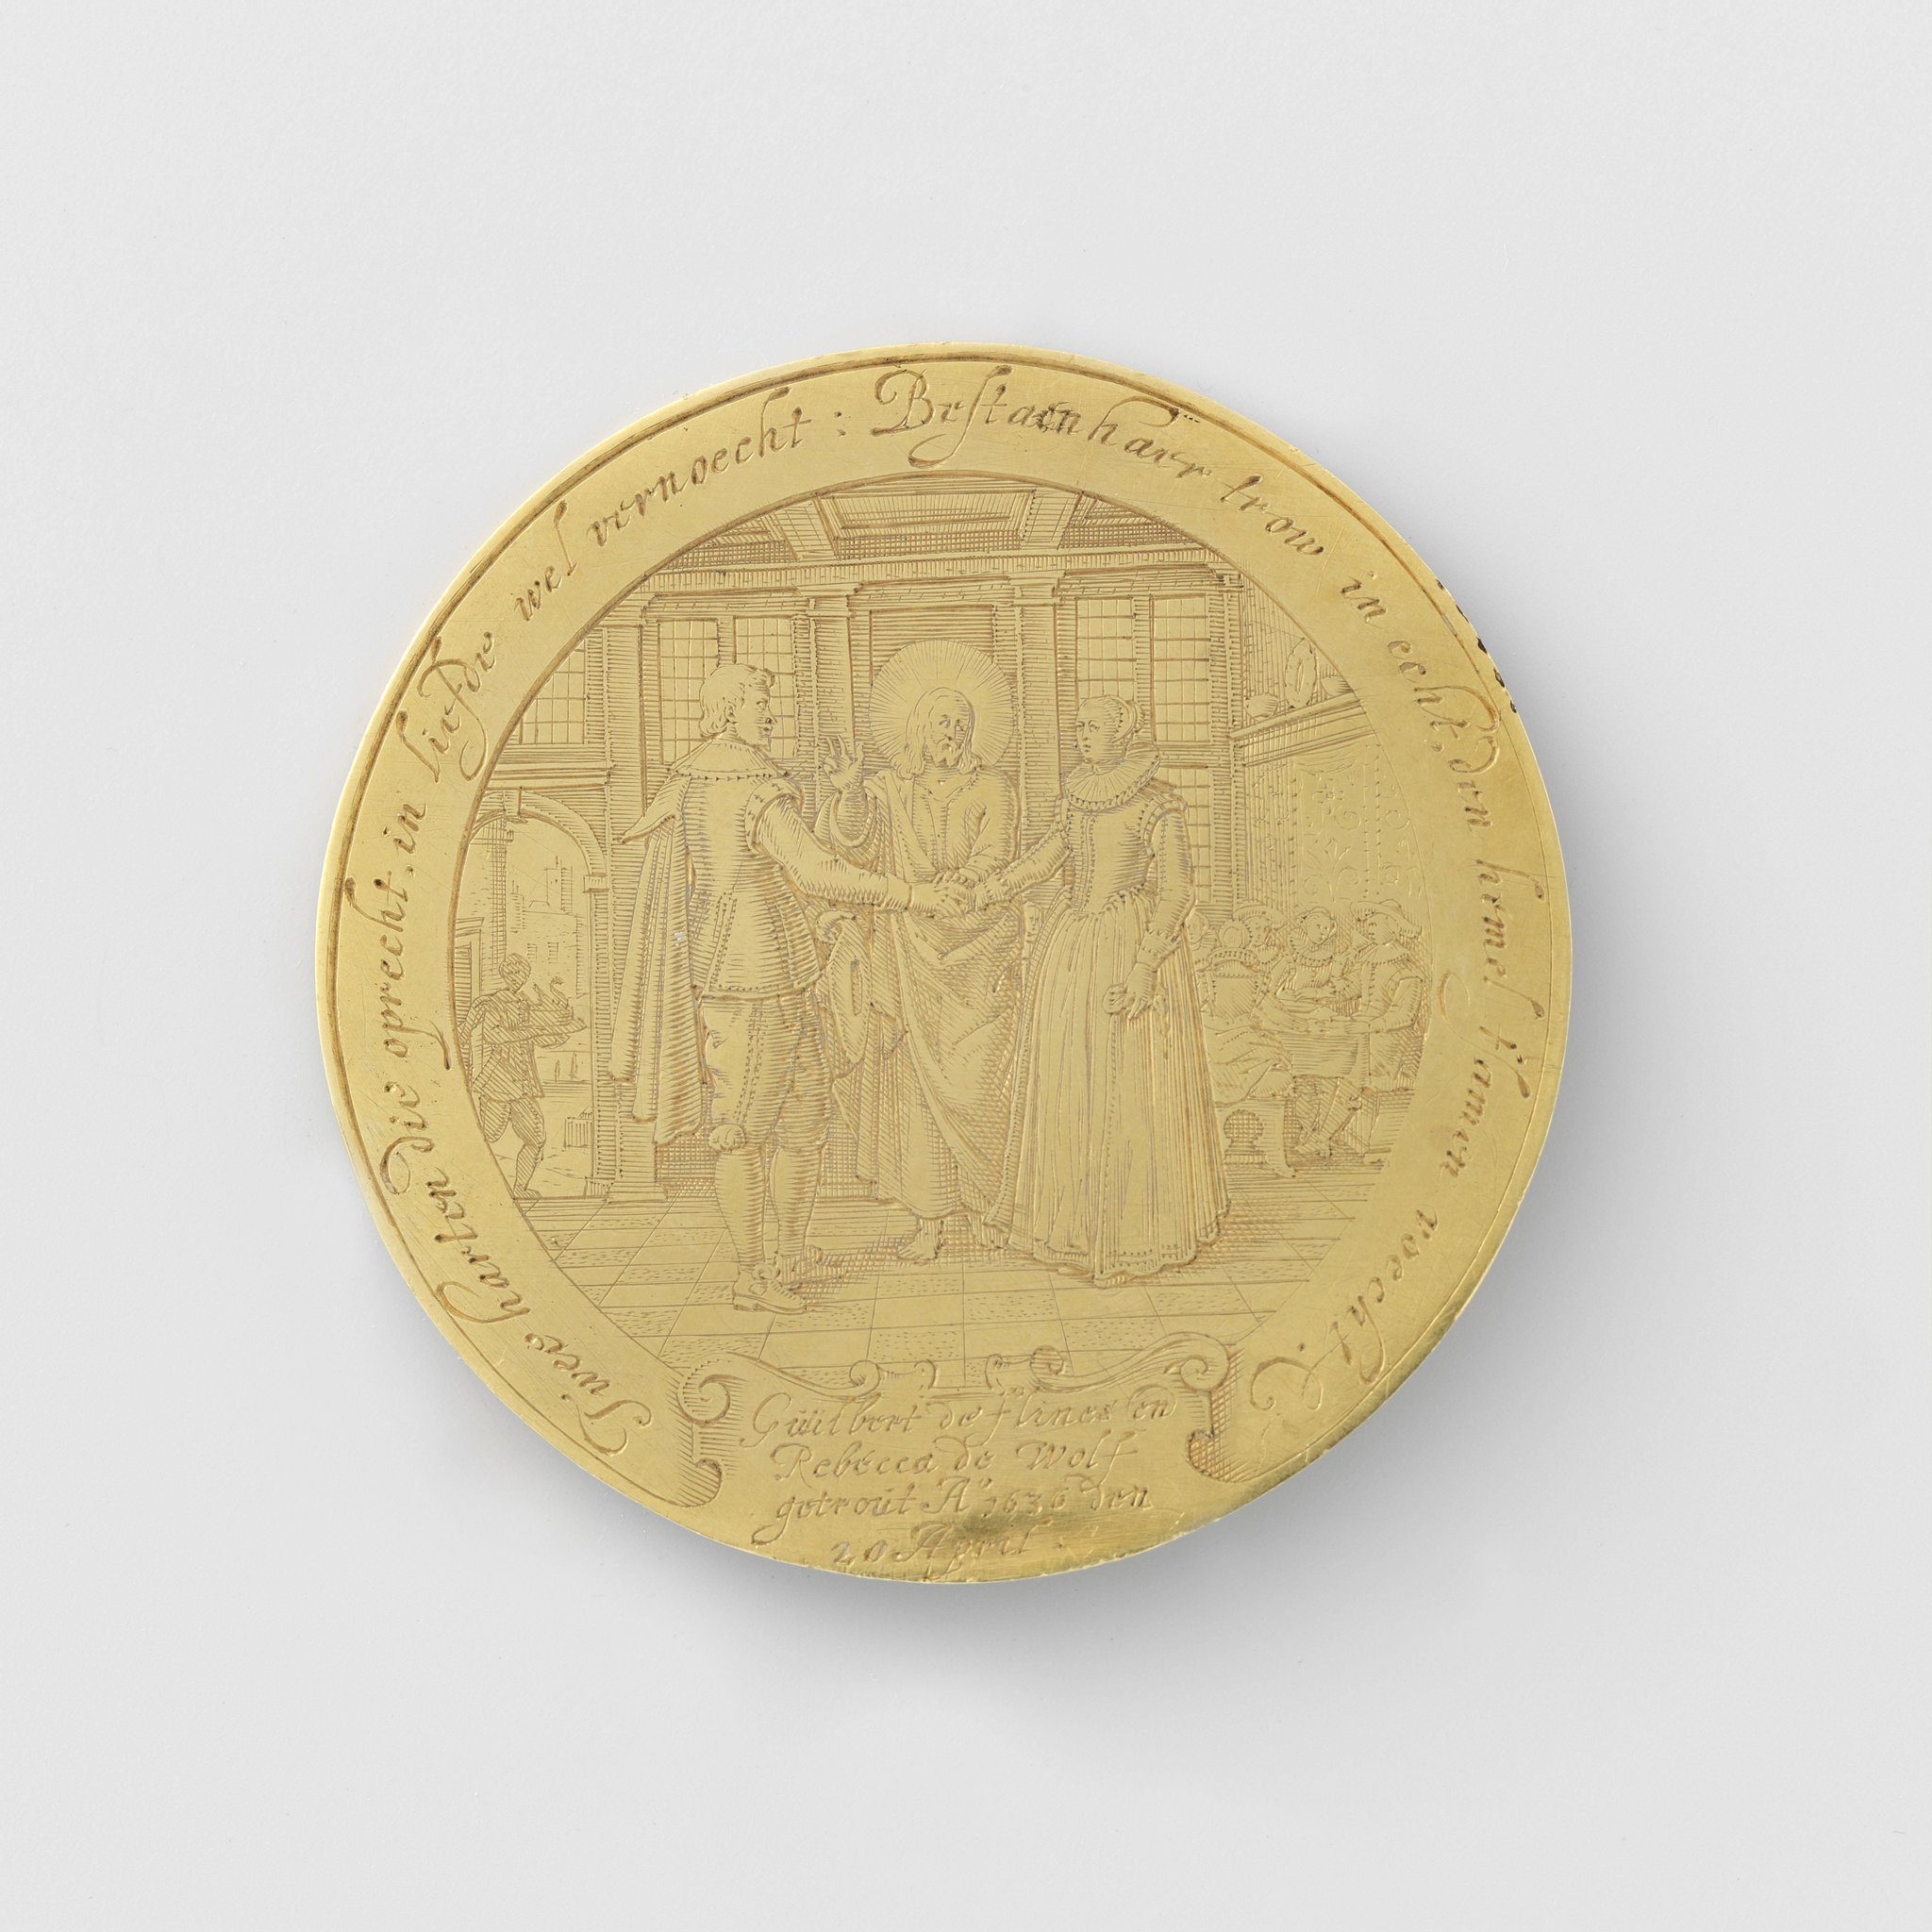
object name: marriage medal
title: Huwelijk van Gilbert de Flines en Rebecca de Wolff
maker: Anonymous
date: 1636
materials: gold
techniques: engraving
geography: netherlands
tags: wedding feast, wedding meal, christ, (civil) marriage ceremonies